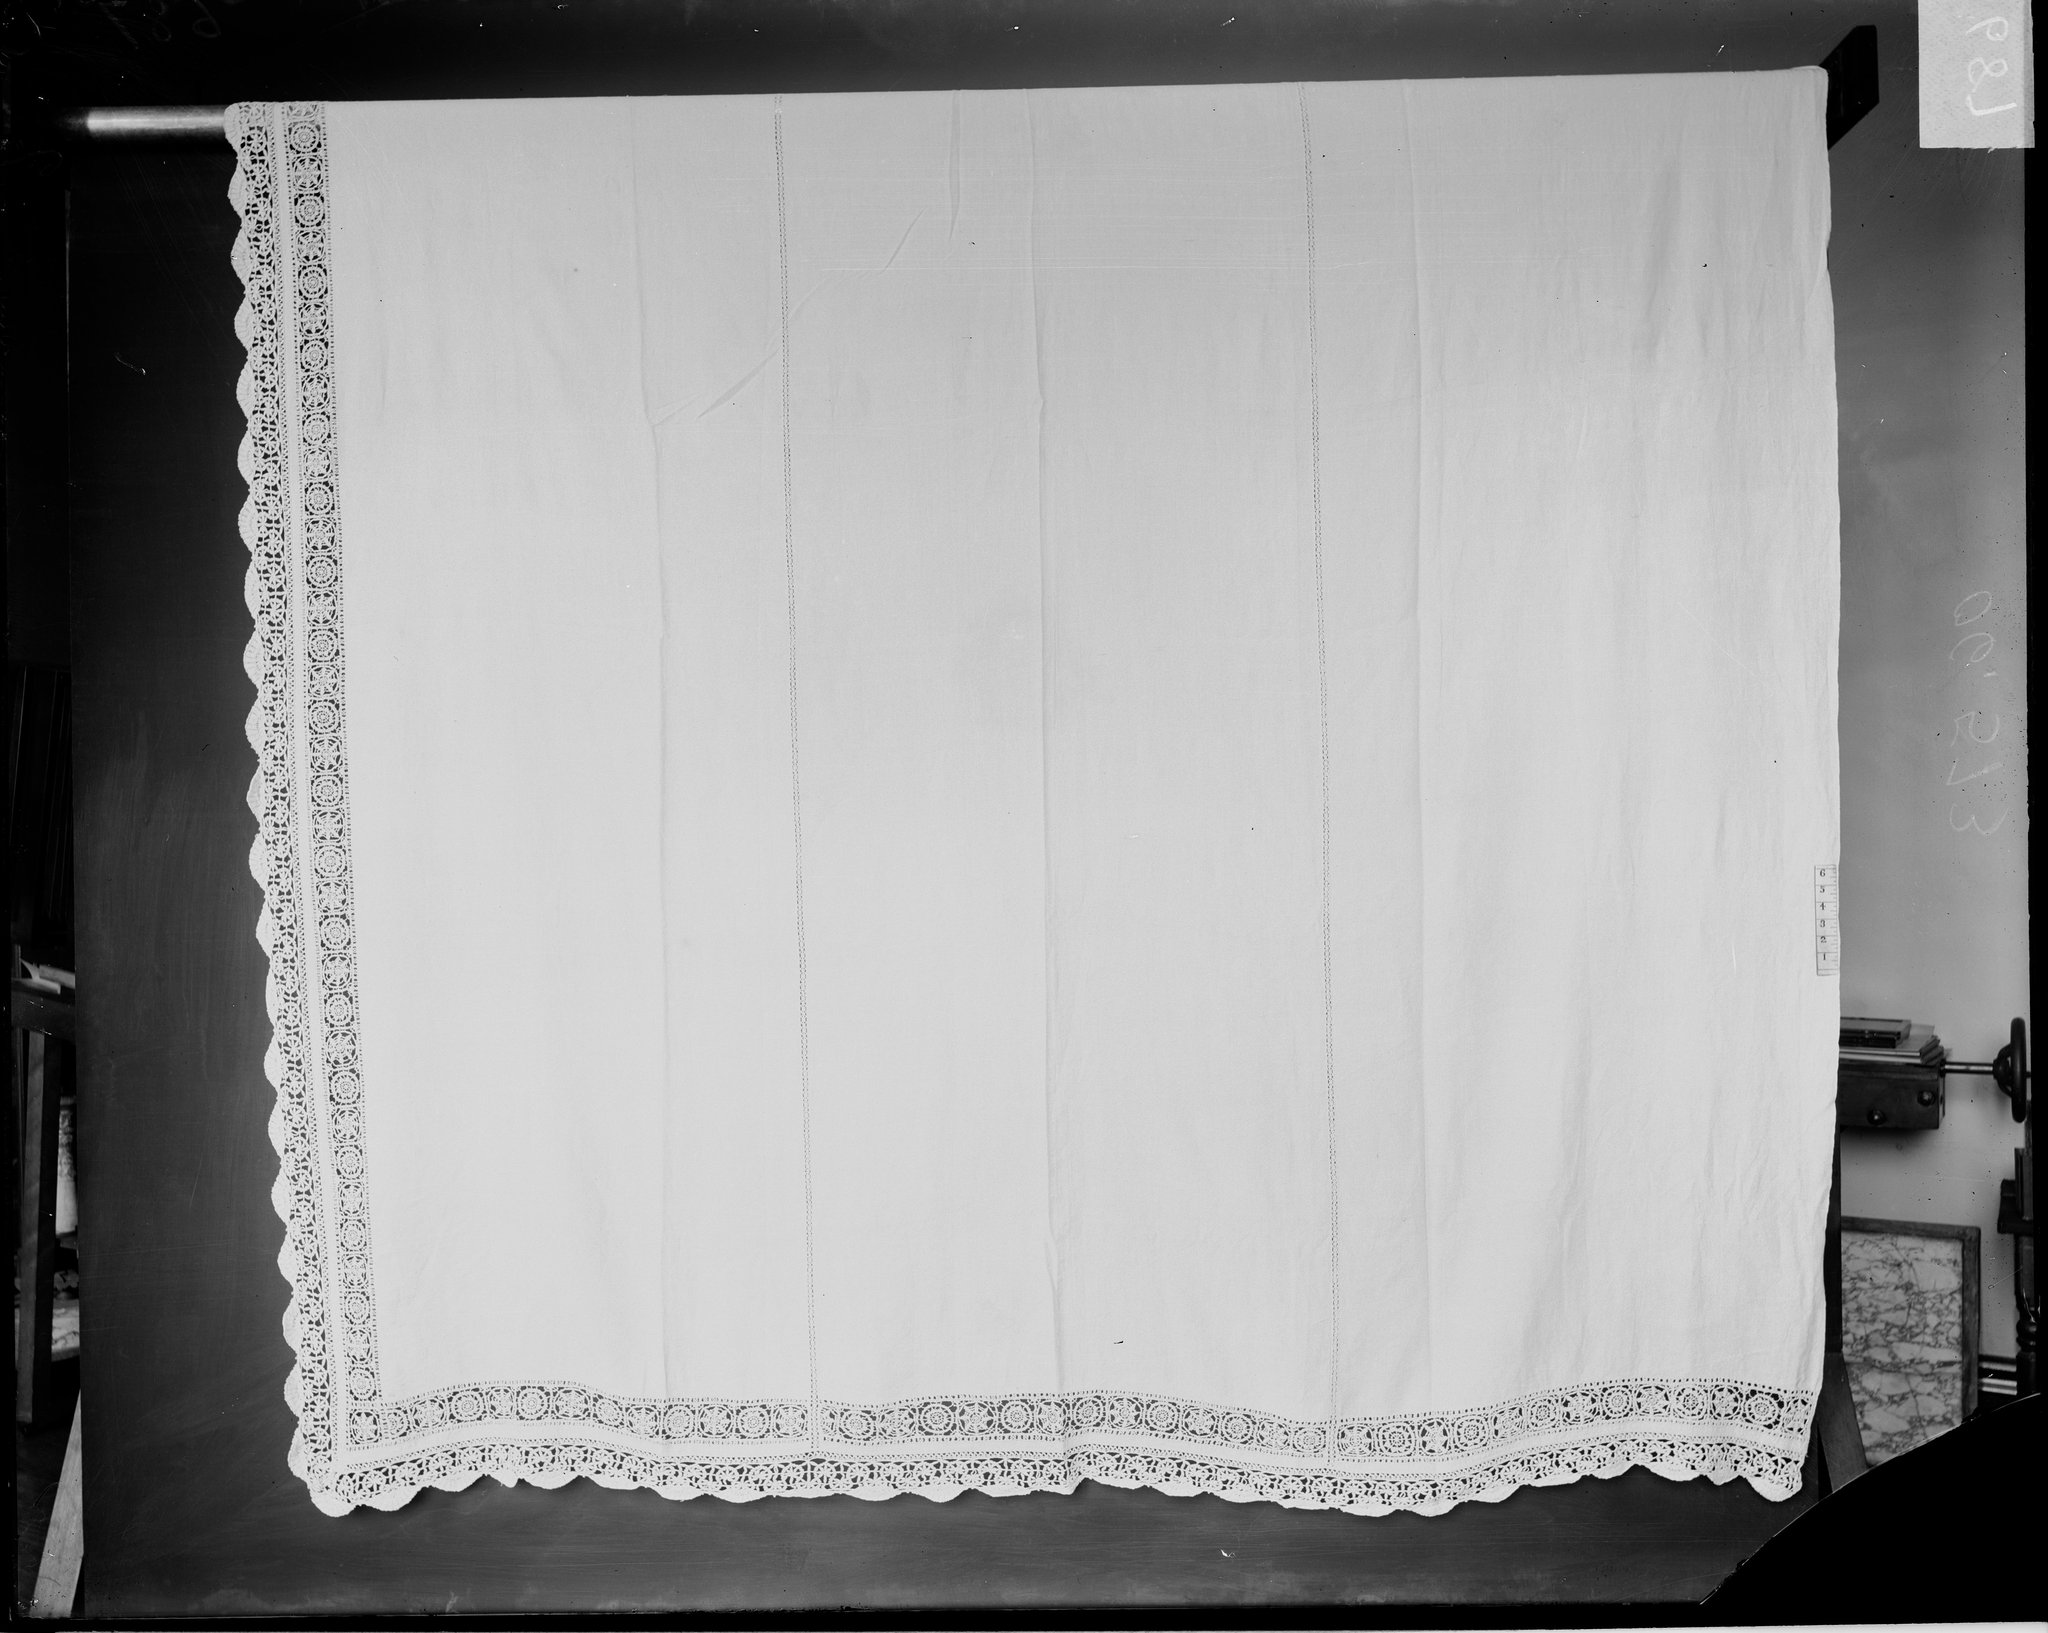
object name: sheet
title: Linen sheet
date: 1567-1600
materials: lace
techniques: lace